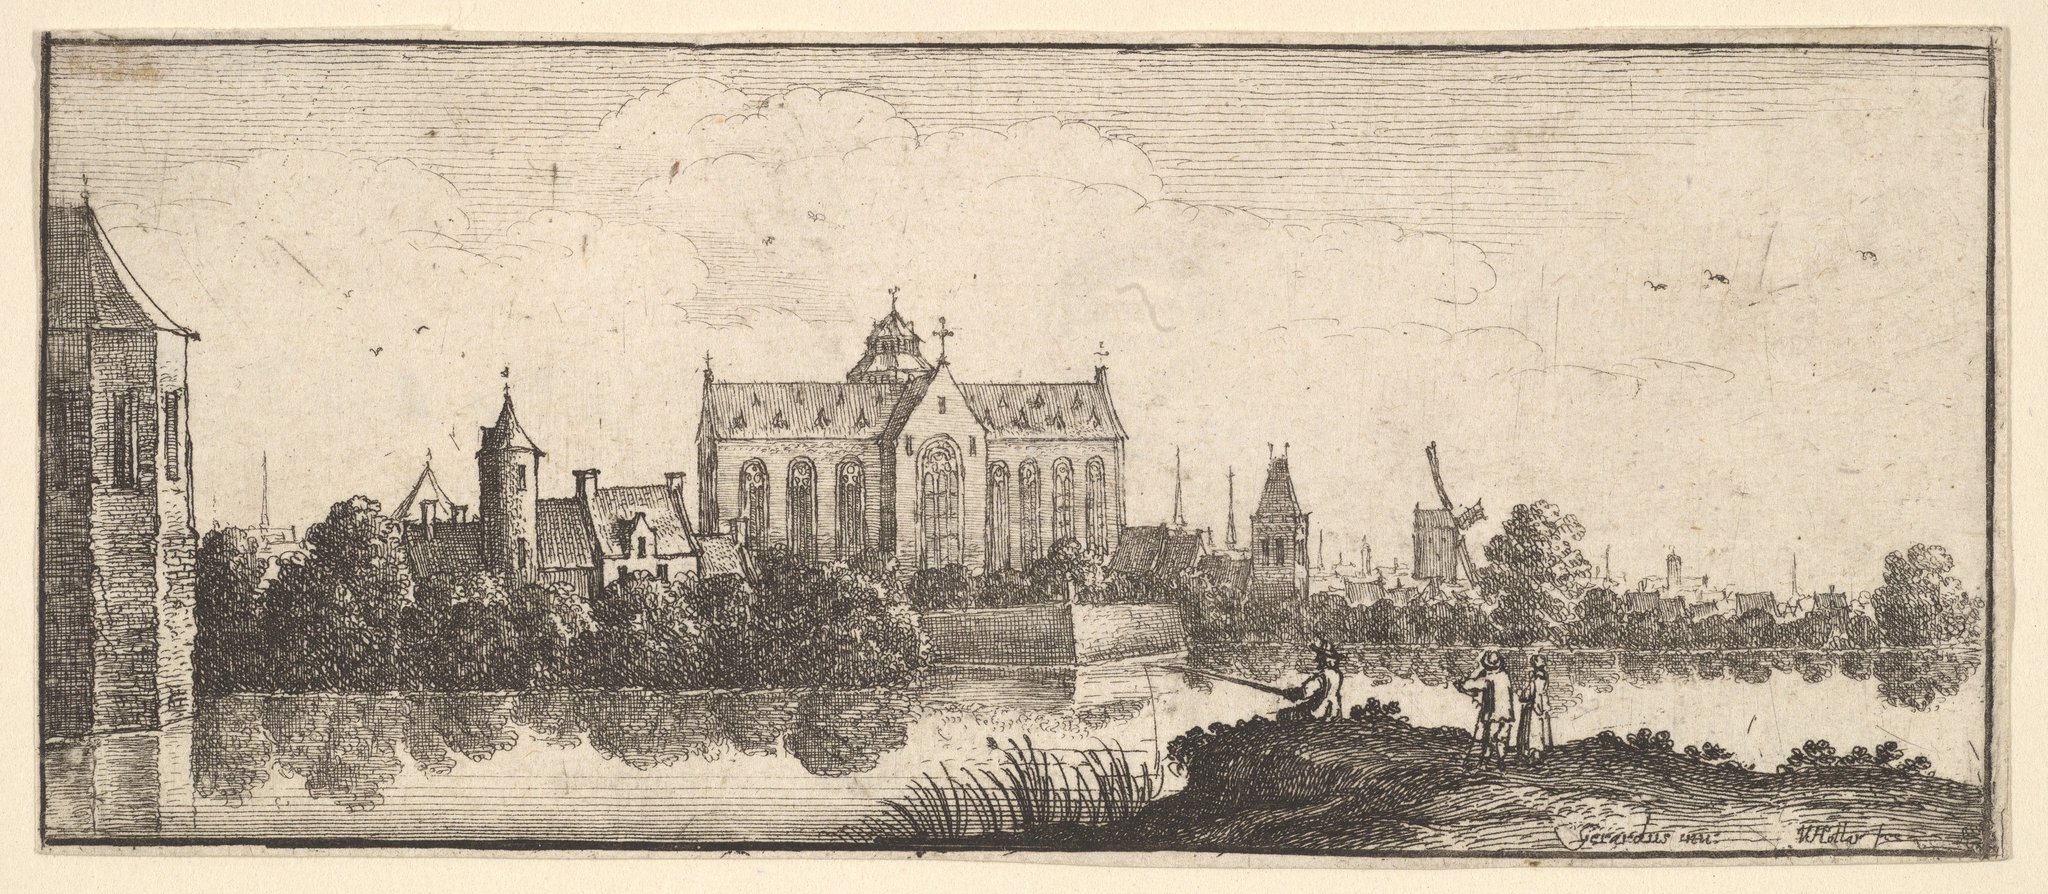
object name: print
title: The Church by the Water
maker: wenceslaus hollar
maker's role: artist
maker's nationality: bohemian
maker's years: 1607-1677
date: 1625-1677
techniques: etching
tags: churches,fishing